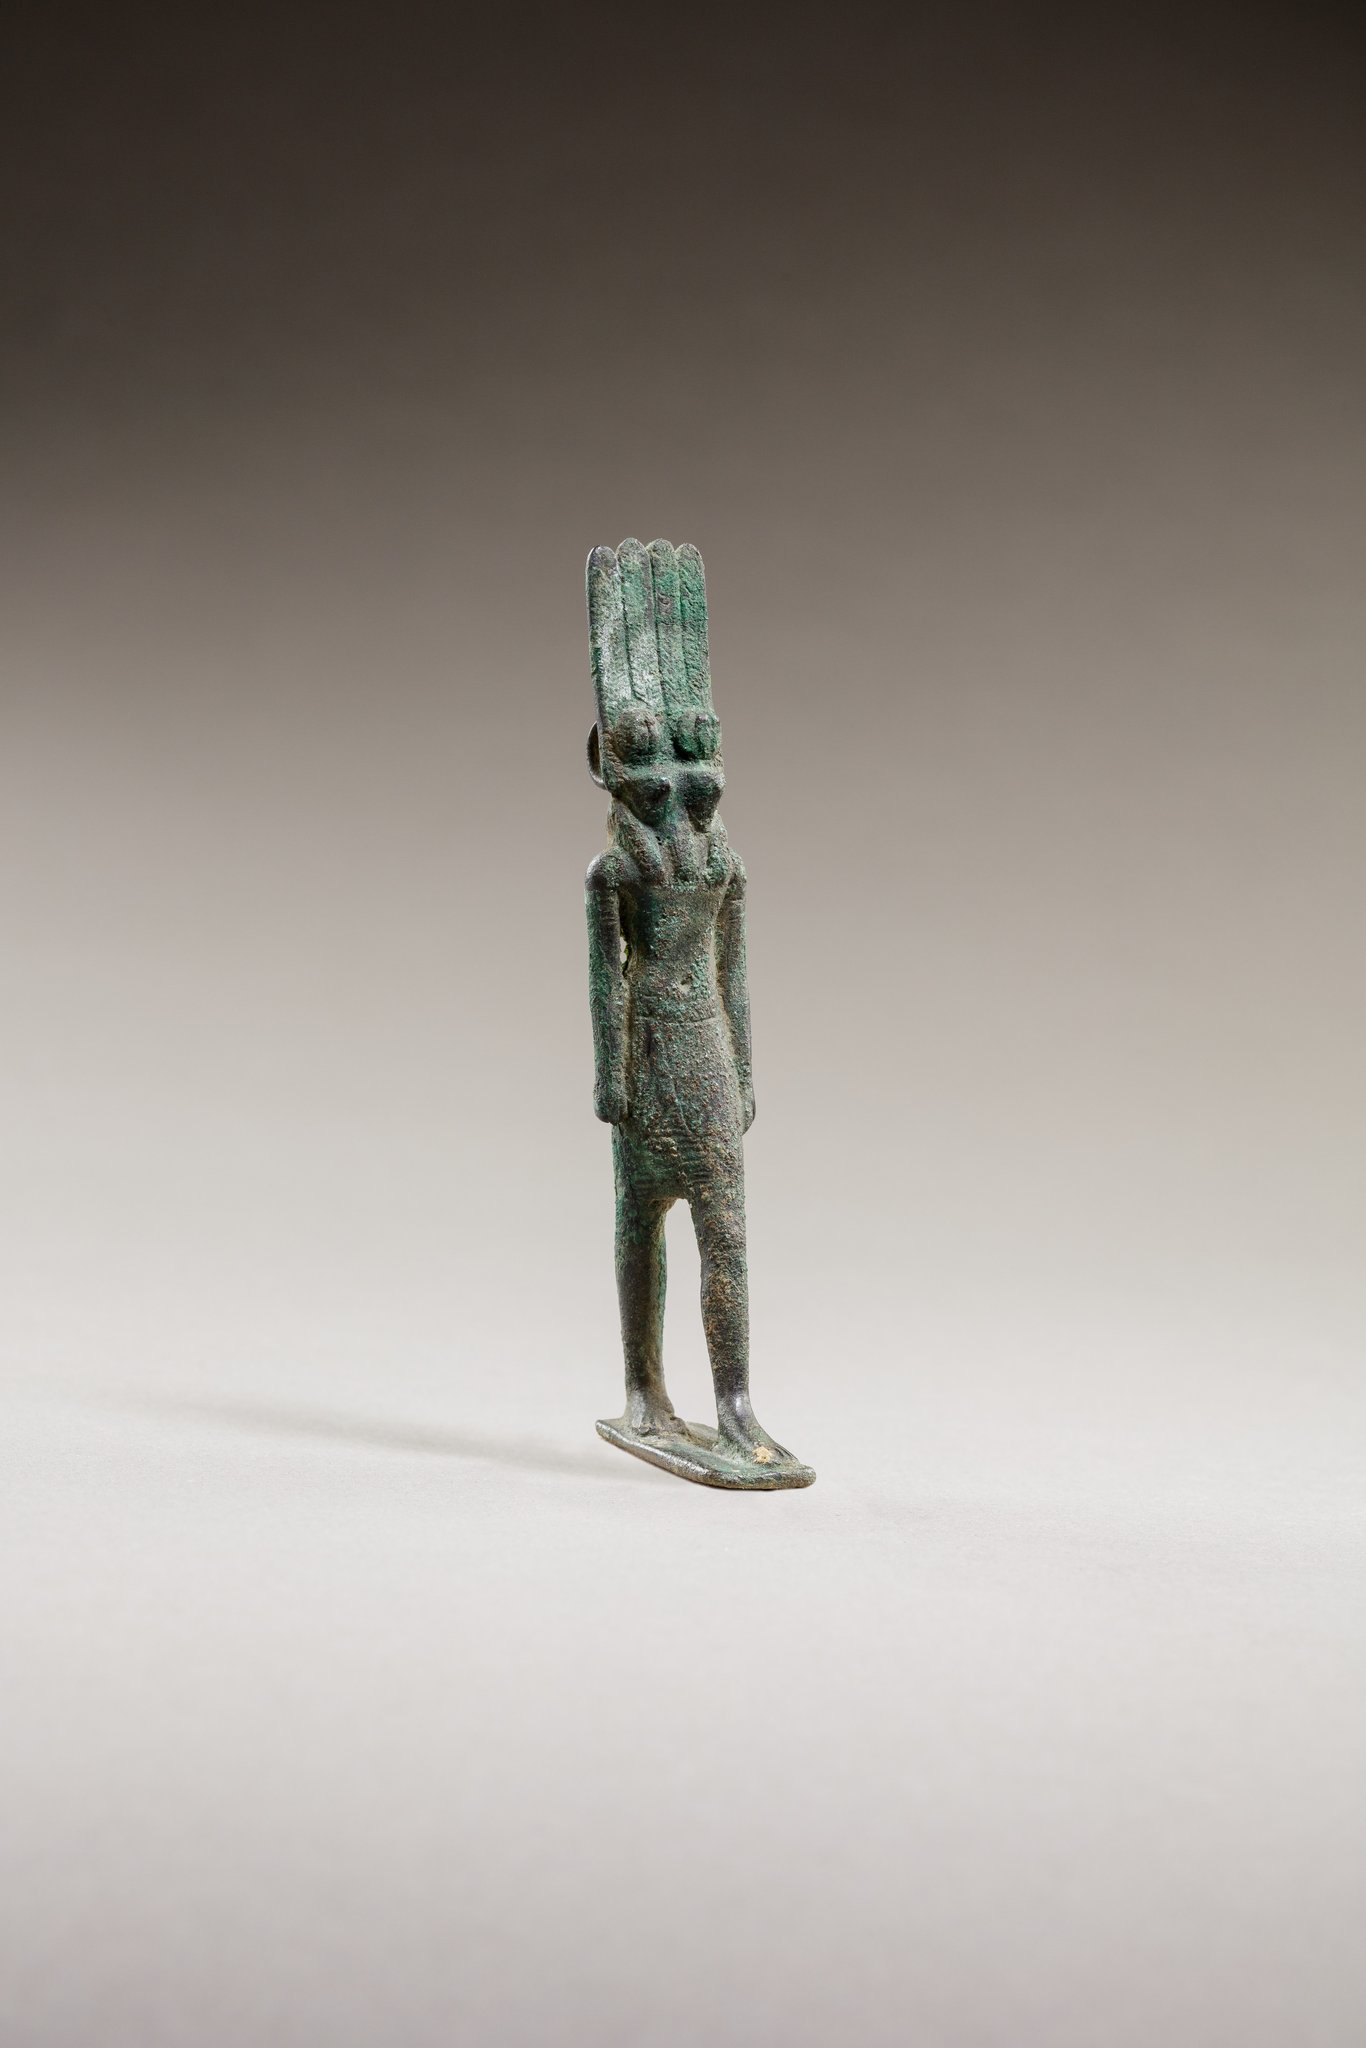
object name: statuette, montu, double head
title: Montu with two heads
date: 664-630 BCE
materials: bronze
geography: egypt